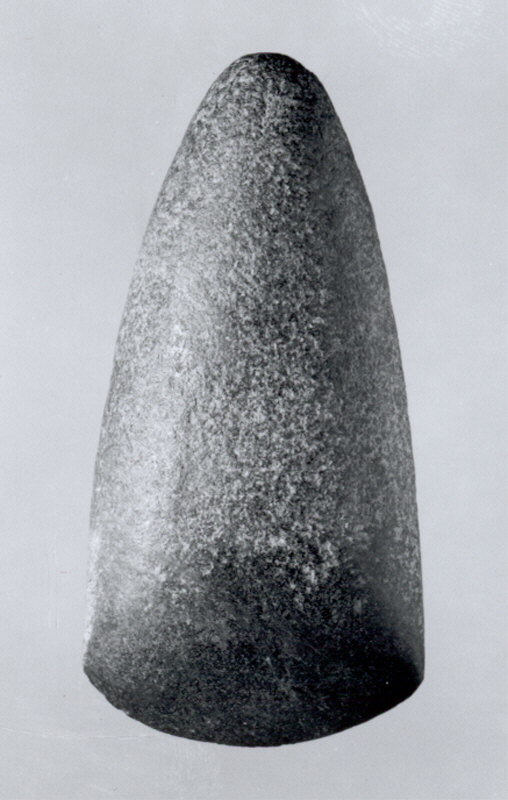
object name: chisel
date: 3000-2001 BCE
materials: stone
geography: anatolia